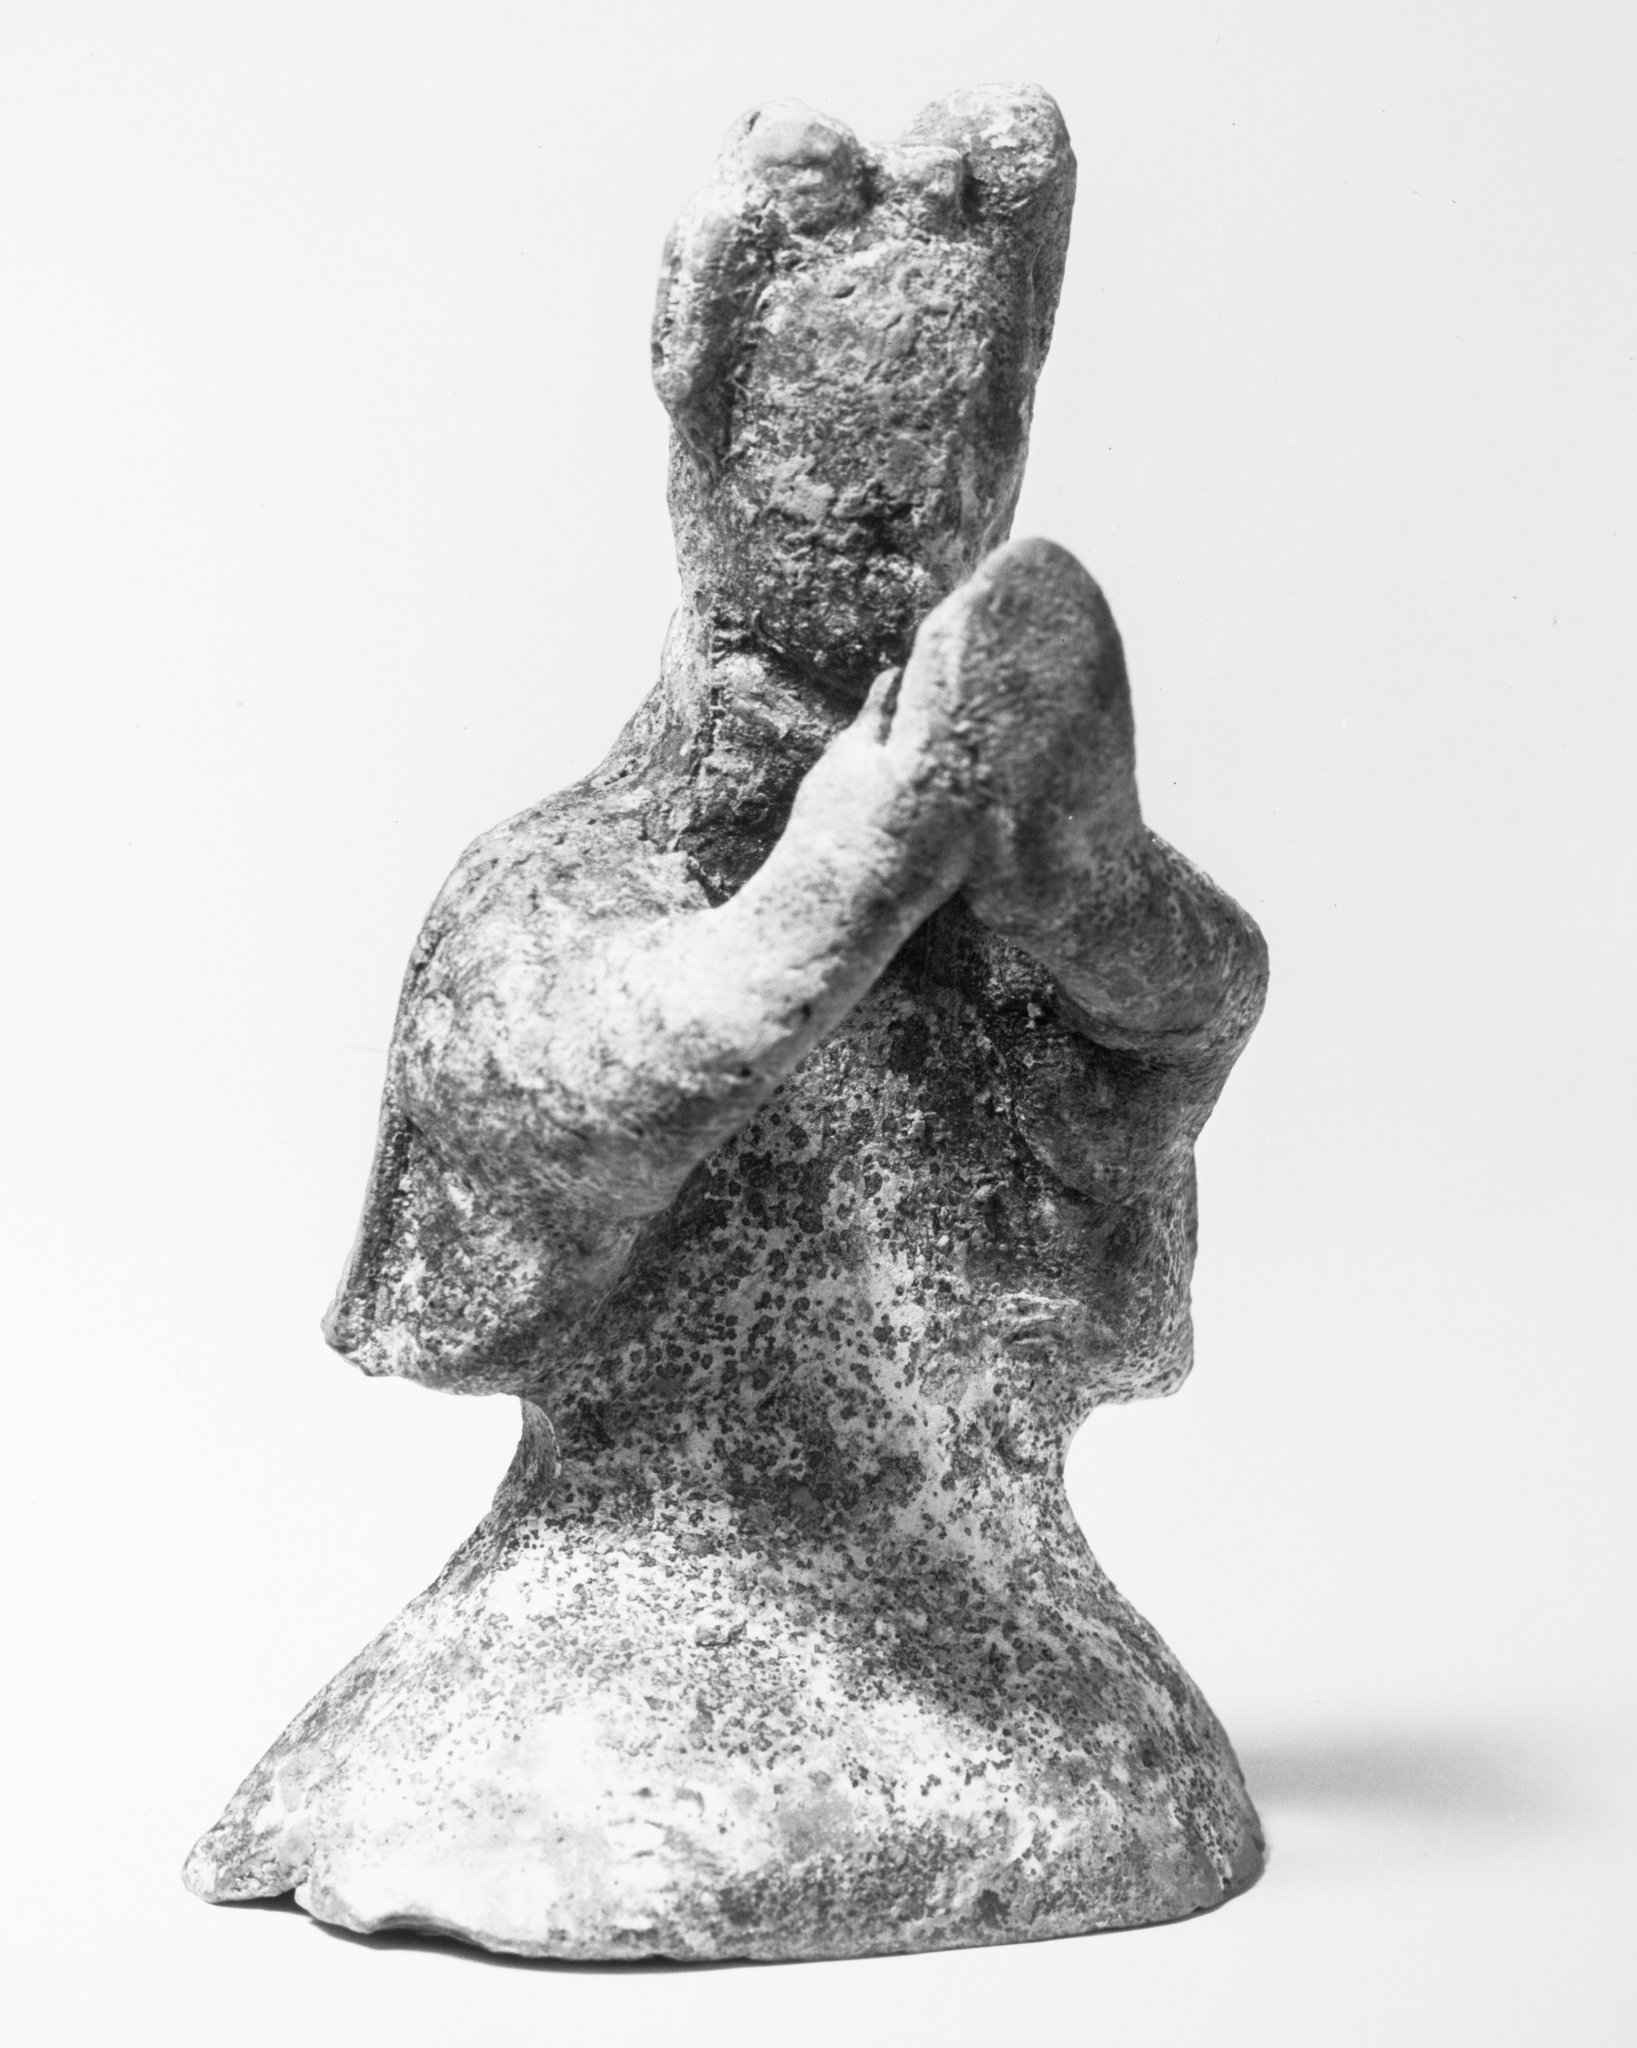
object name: figure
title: Figure of Entertainer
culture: chinese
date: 206 BCE-220 CE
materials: paint, pottery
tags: human figures